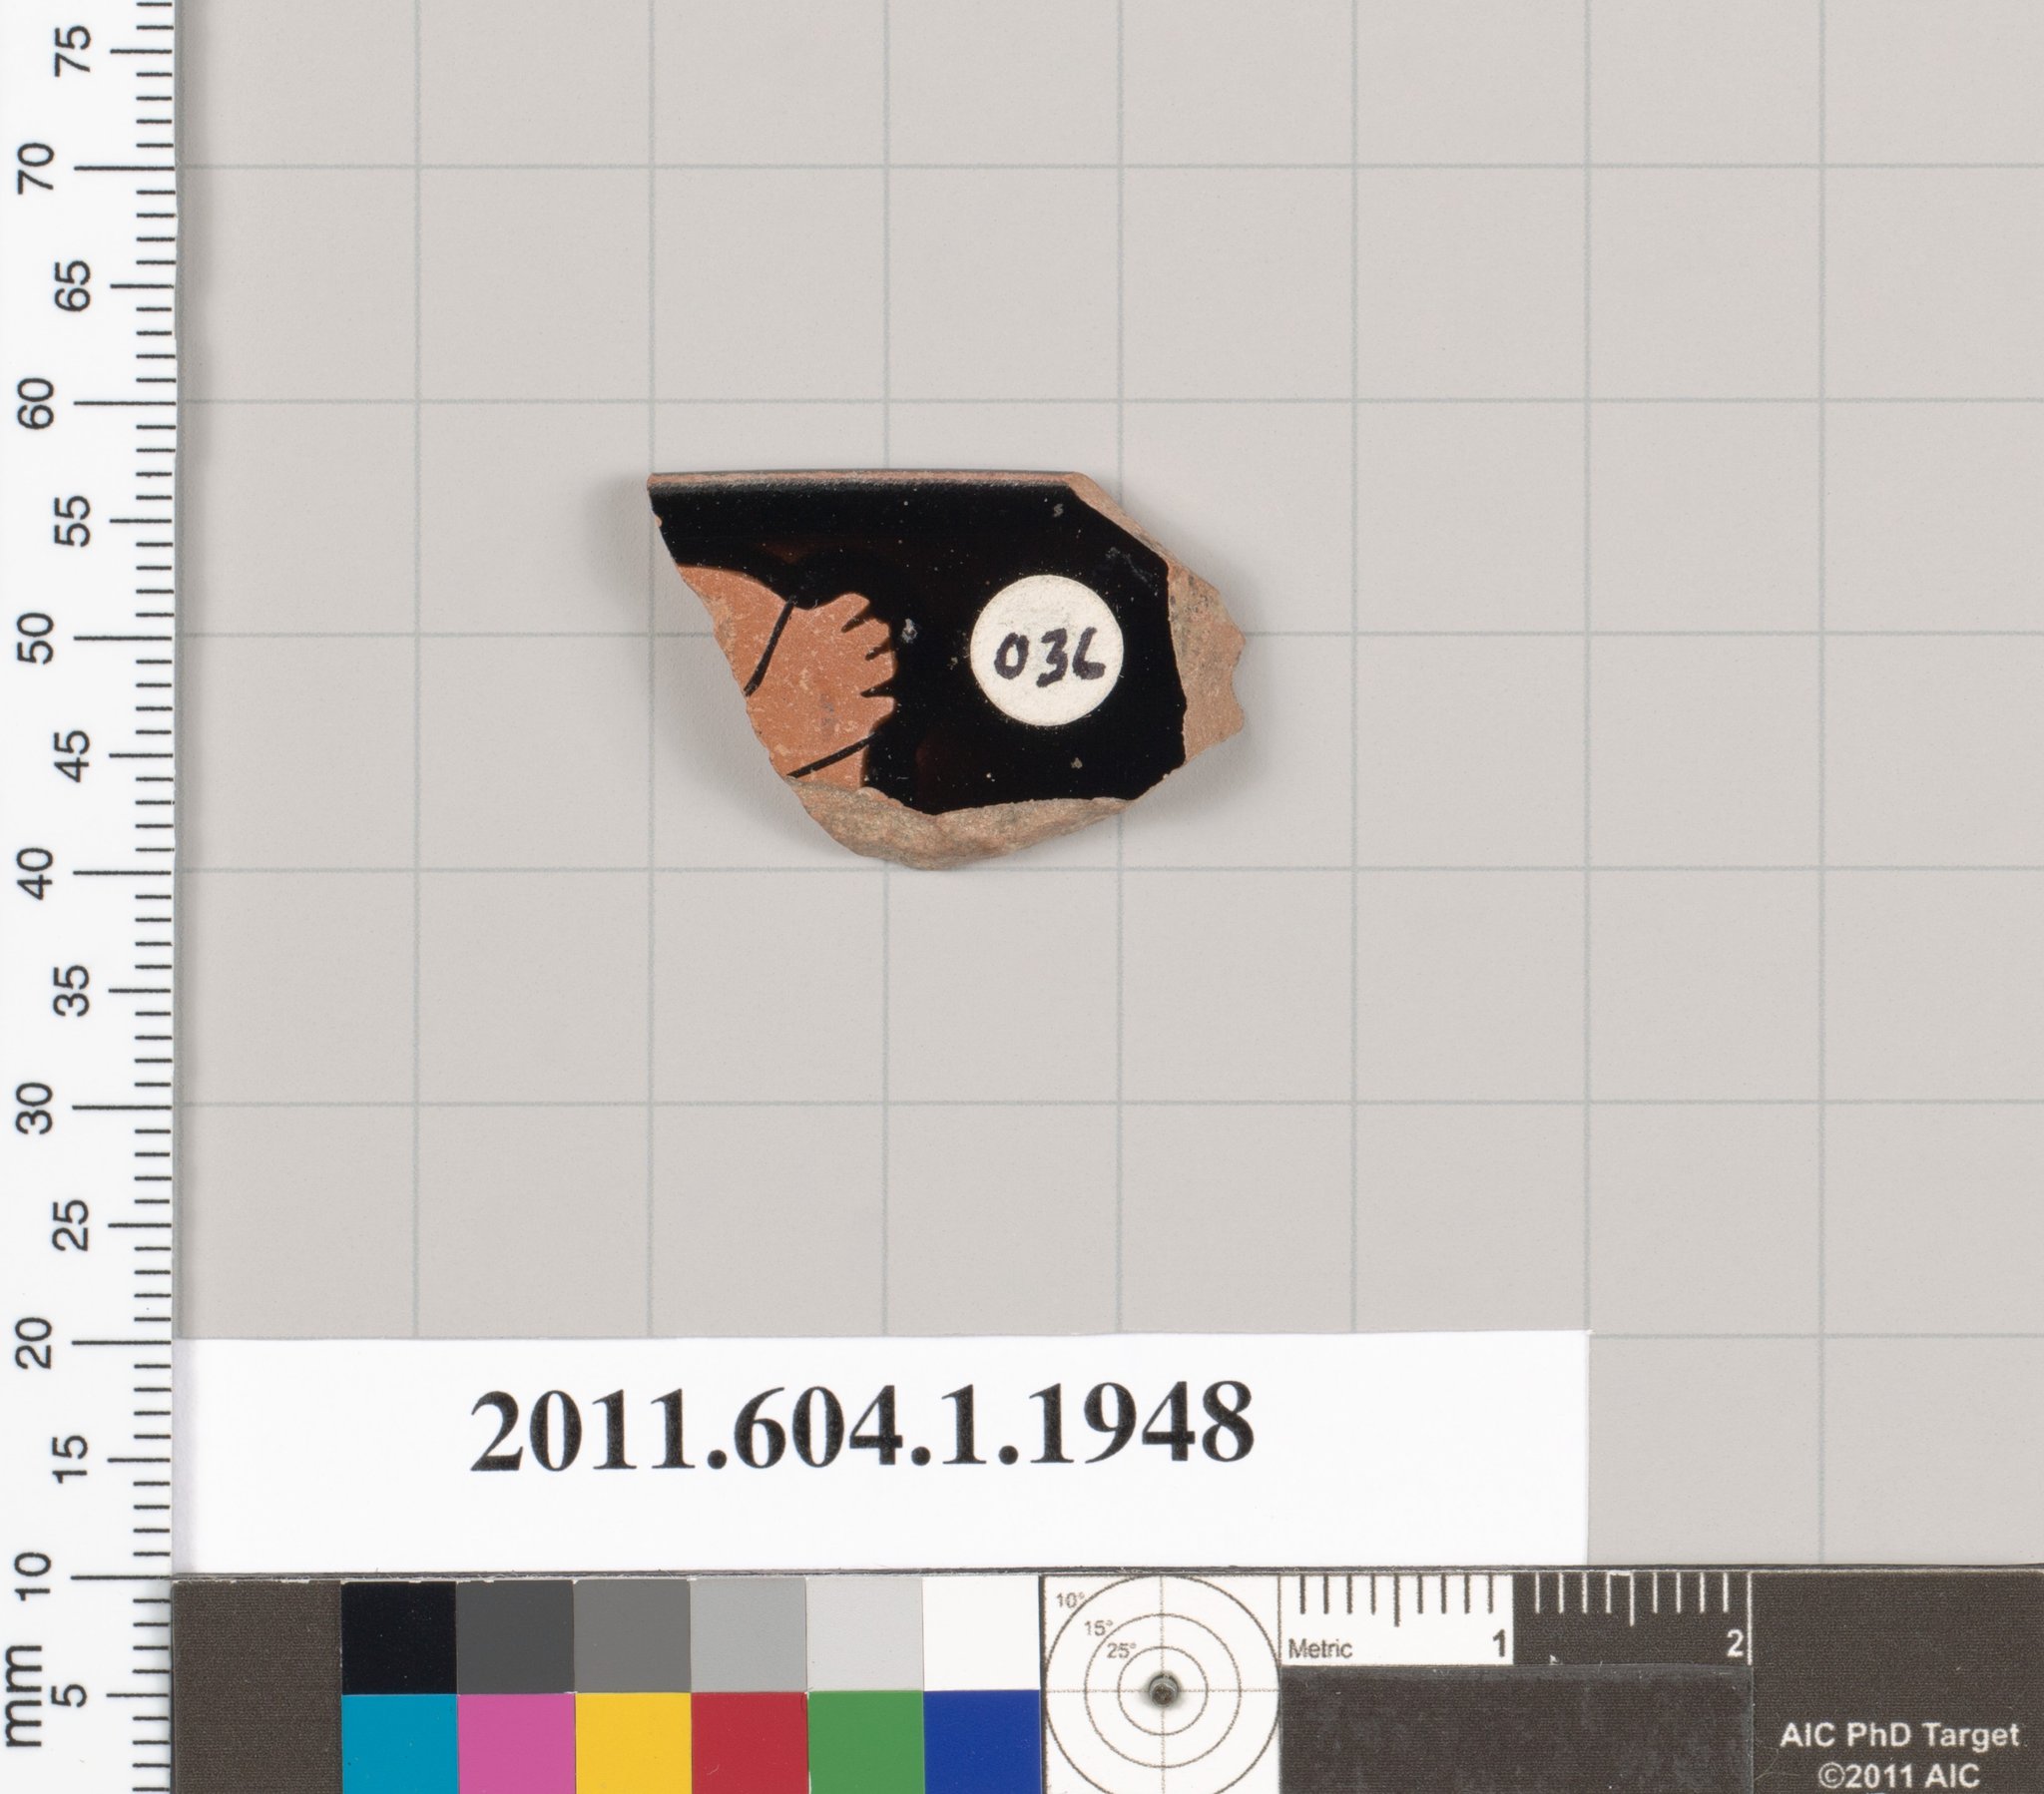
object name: kylix fragment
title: Terracotta rim fragment of a kylix (drinking cup)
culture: greek, attic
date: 490-480 BCE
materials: terracotta